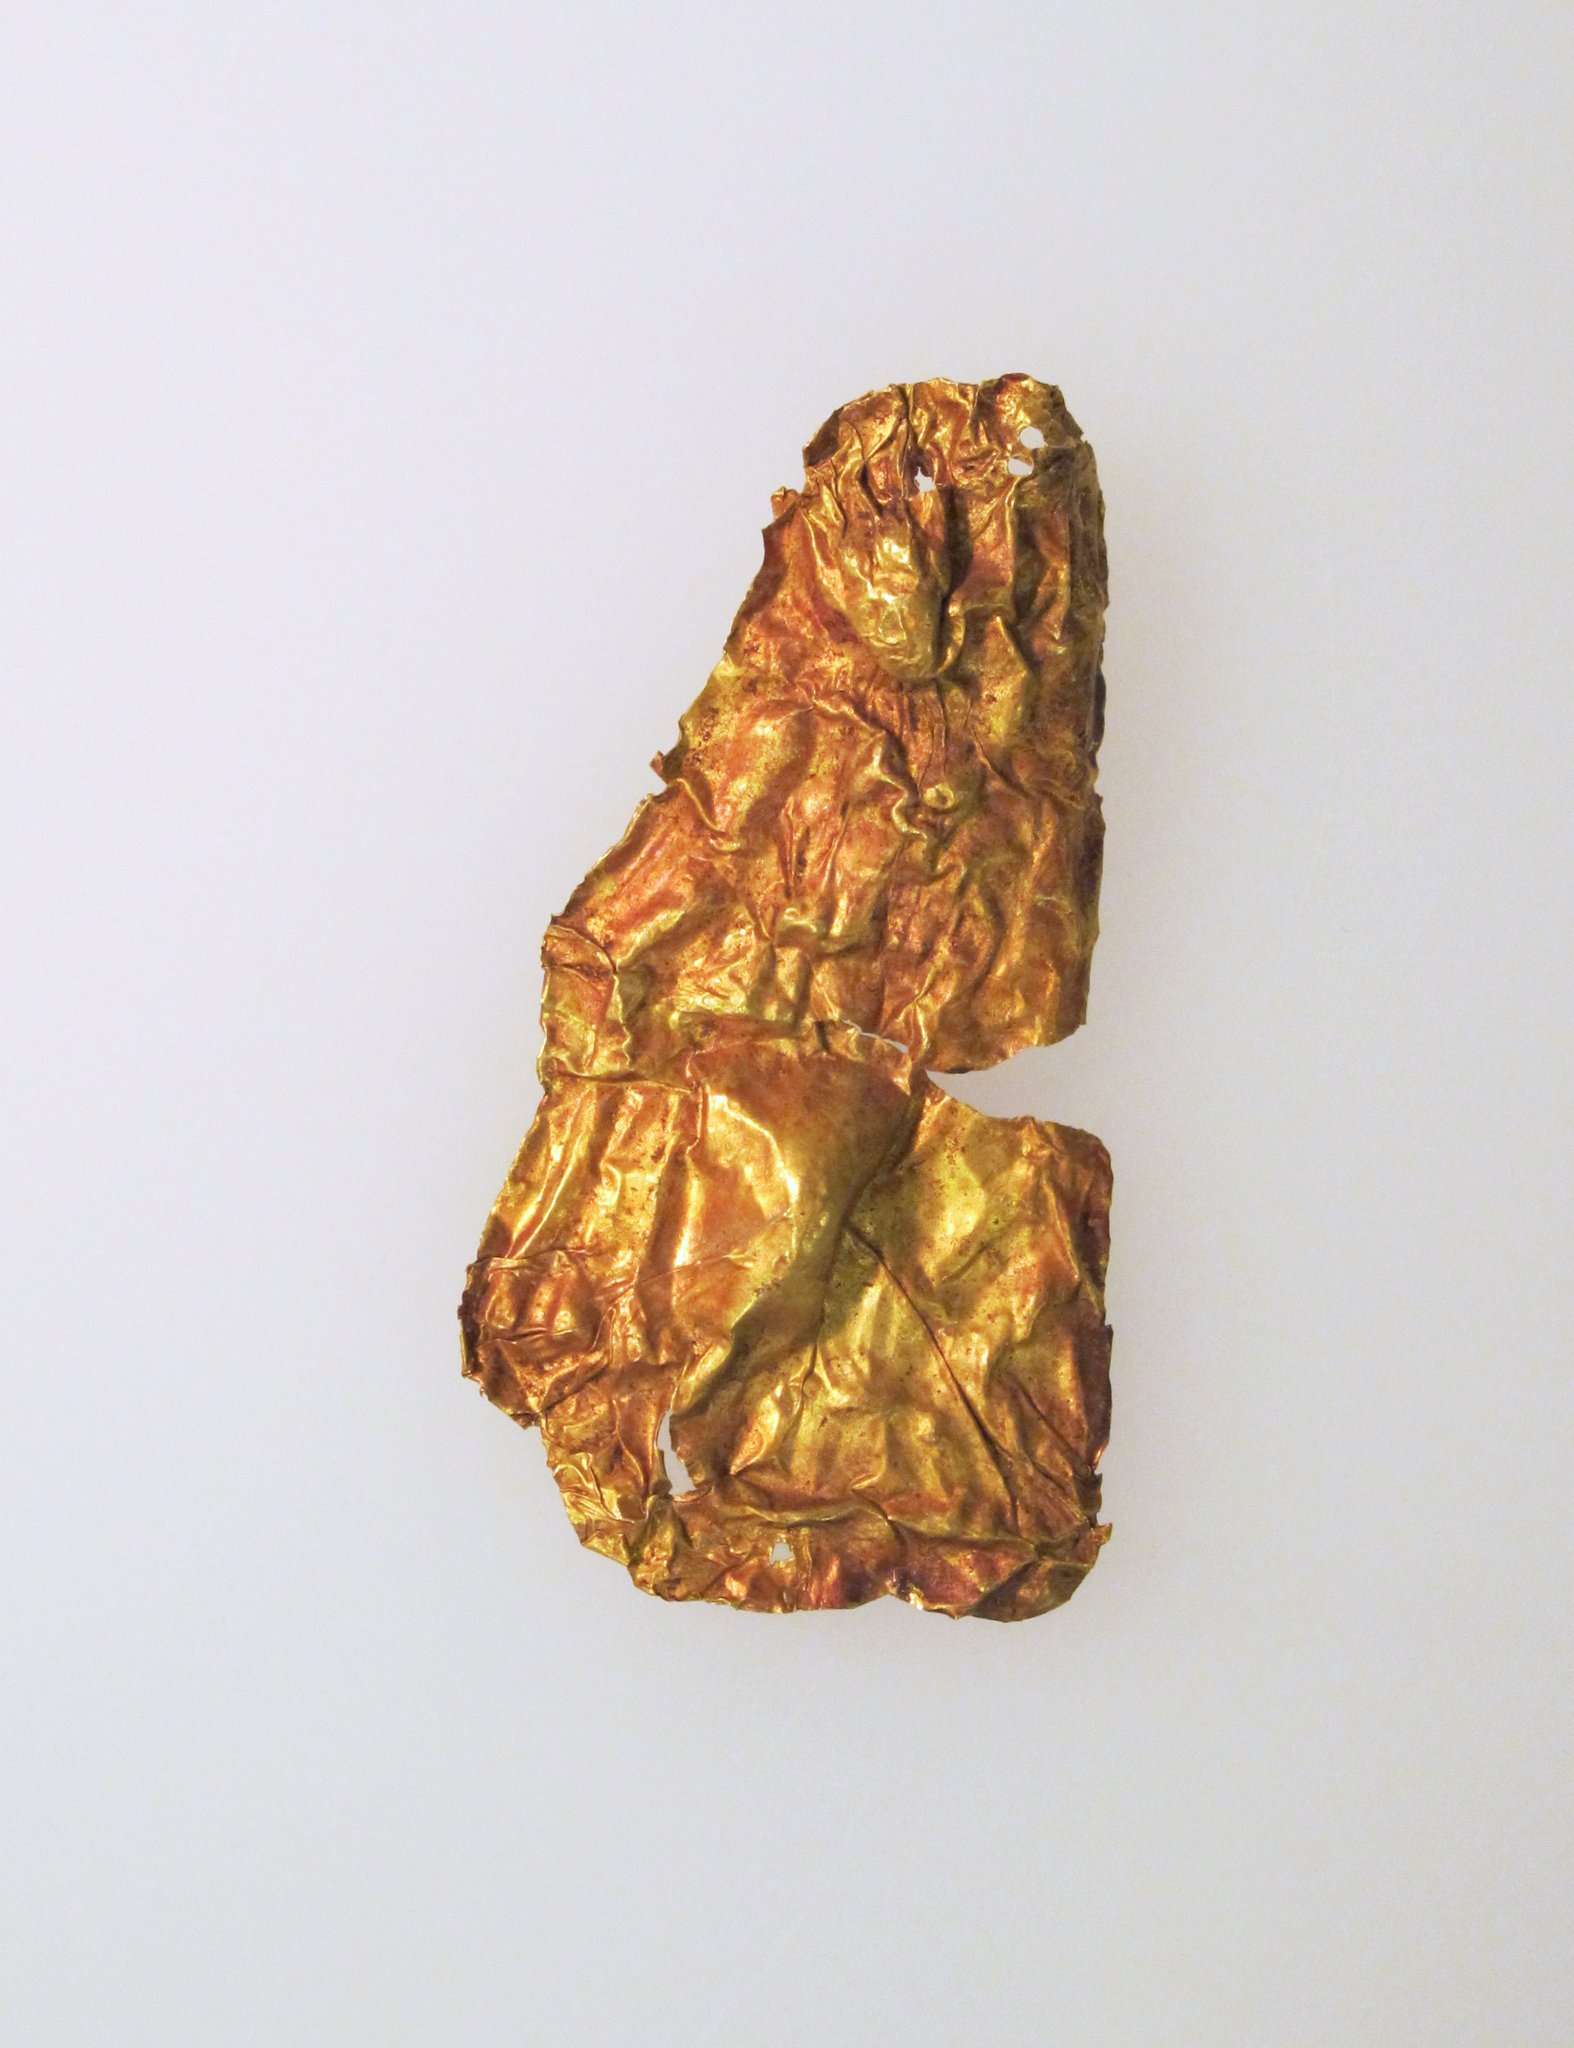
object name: plaque with female figure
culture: etruscan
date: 900-100 BCE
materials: gold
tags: women